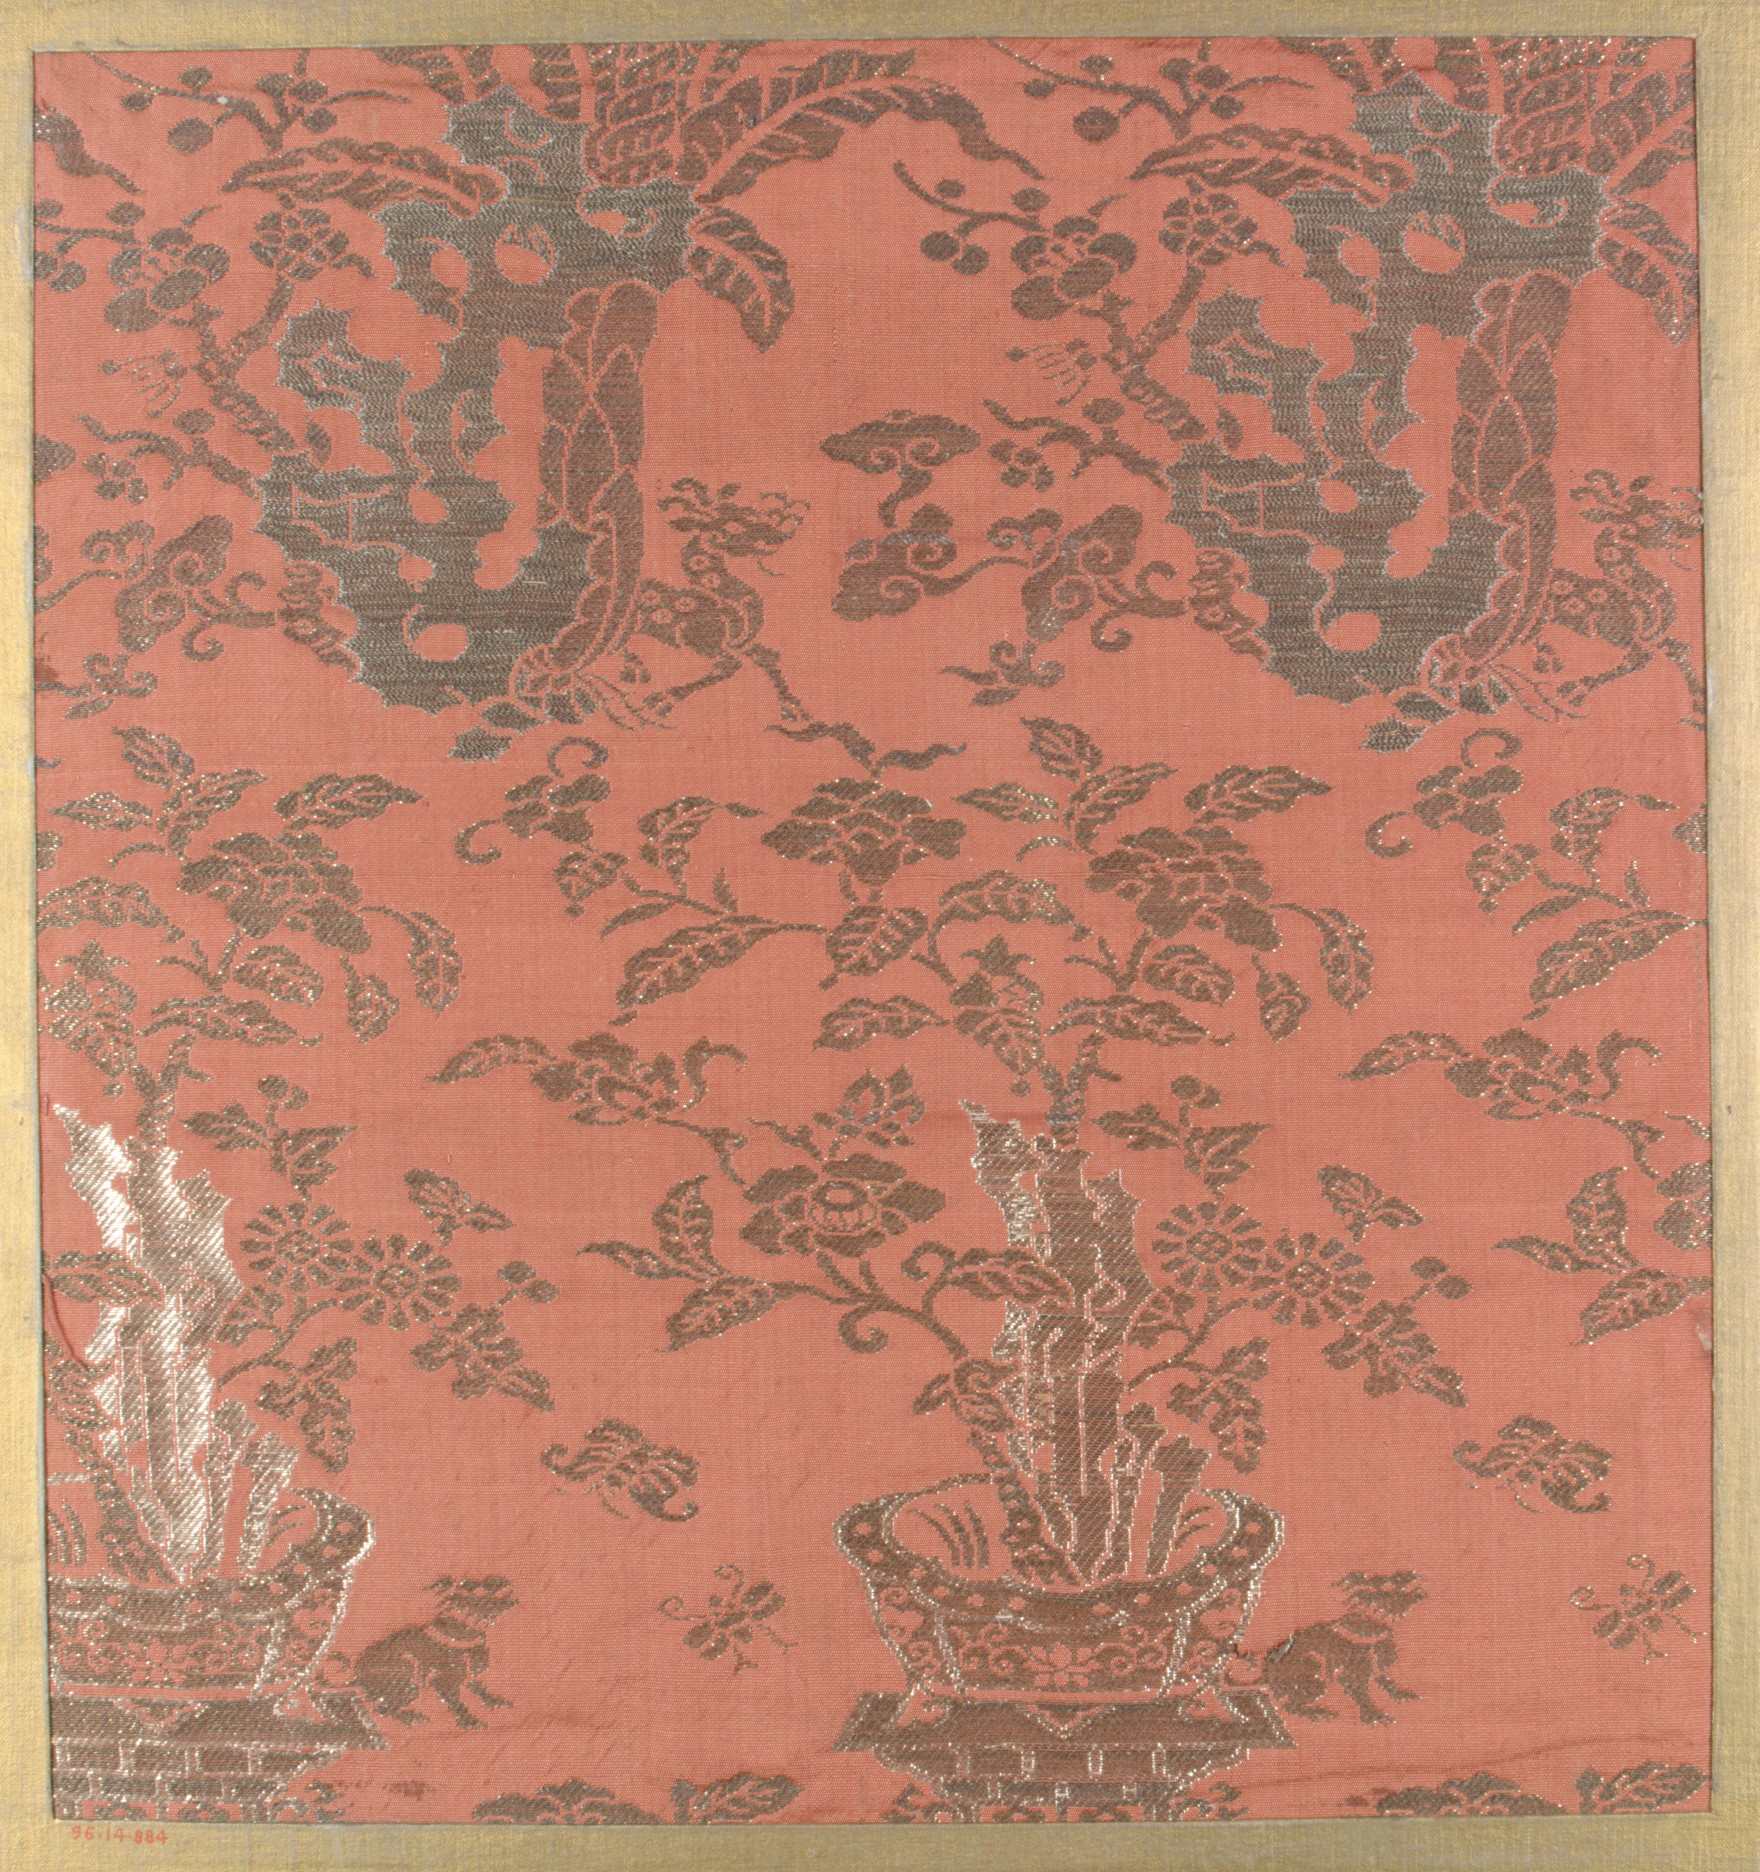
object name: piece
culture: japanese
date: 1701-1900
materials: silk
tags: butterflies,flowers,leaves